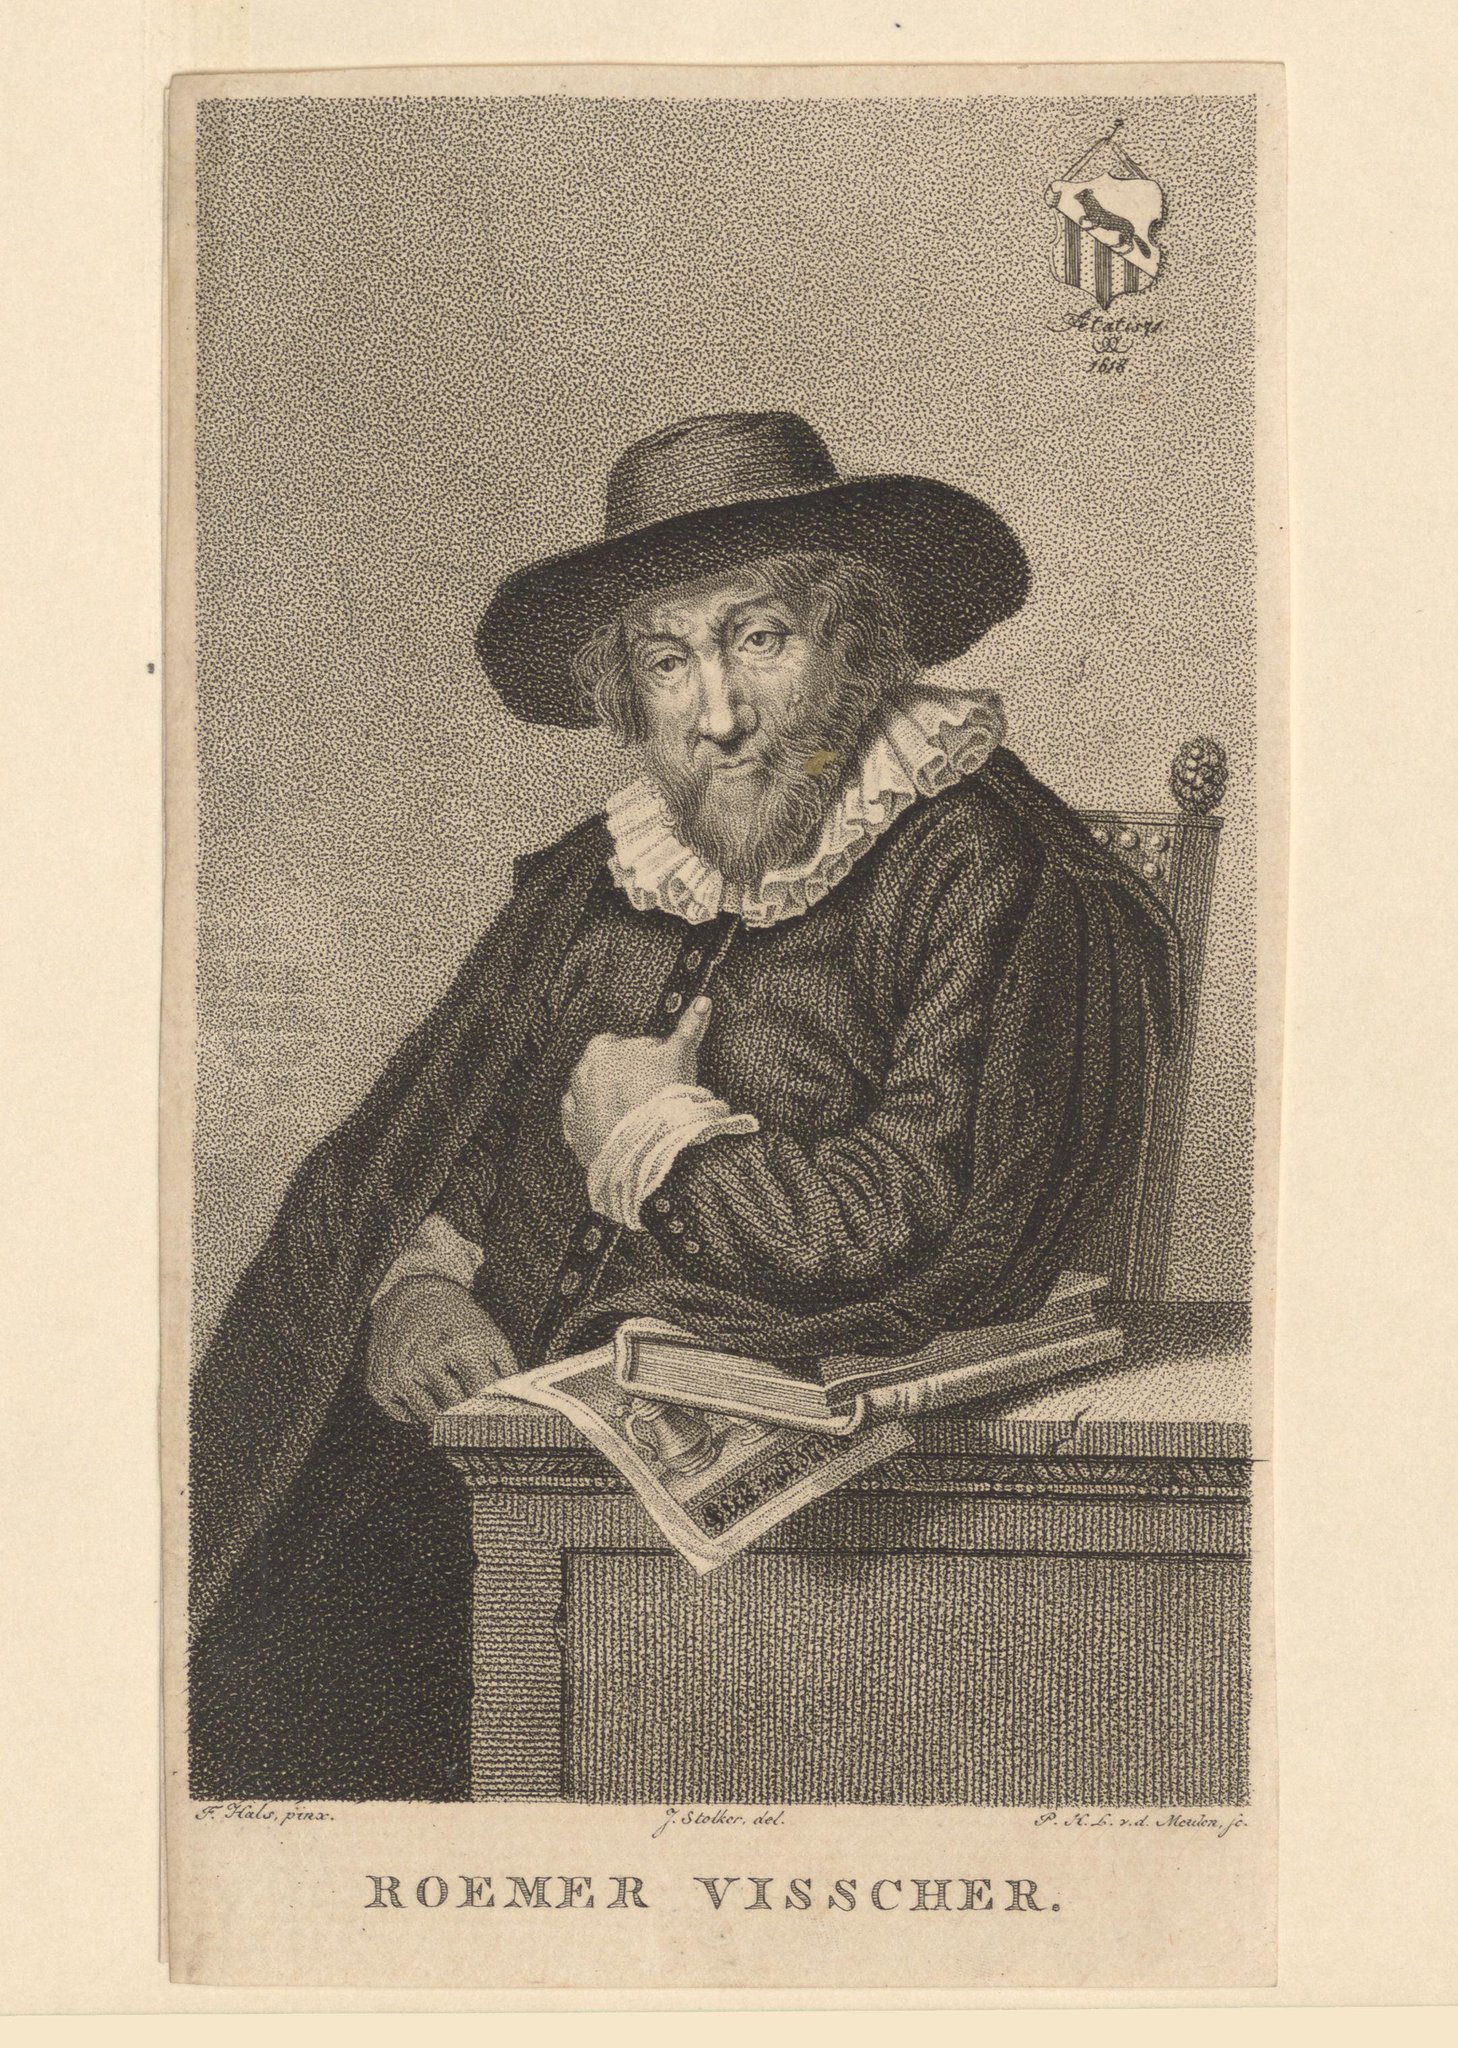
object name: print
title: Portret van Roemer Visscher op 71-jarige leeftijd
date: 1808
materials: paper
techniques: etching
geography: northern netherlands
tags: amsterdam, roemer visscher, historical persons, portrait of a writer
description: Prent waarschijnlijk uit: Scheltema, Jacobus. Anna en Maria Tesselschade, de dochters van Roemer Visscher. Amsterdam: J.W. Ijntema en Comp., 1808.